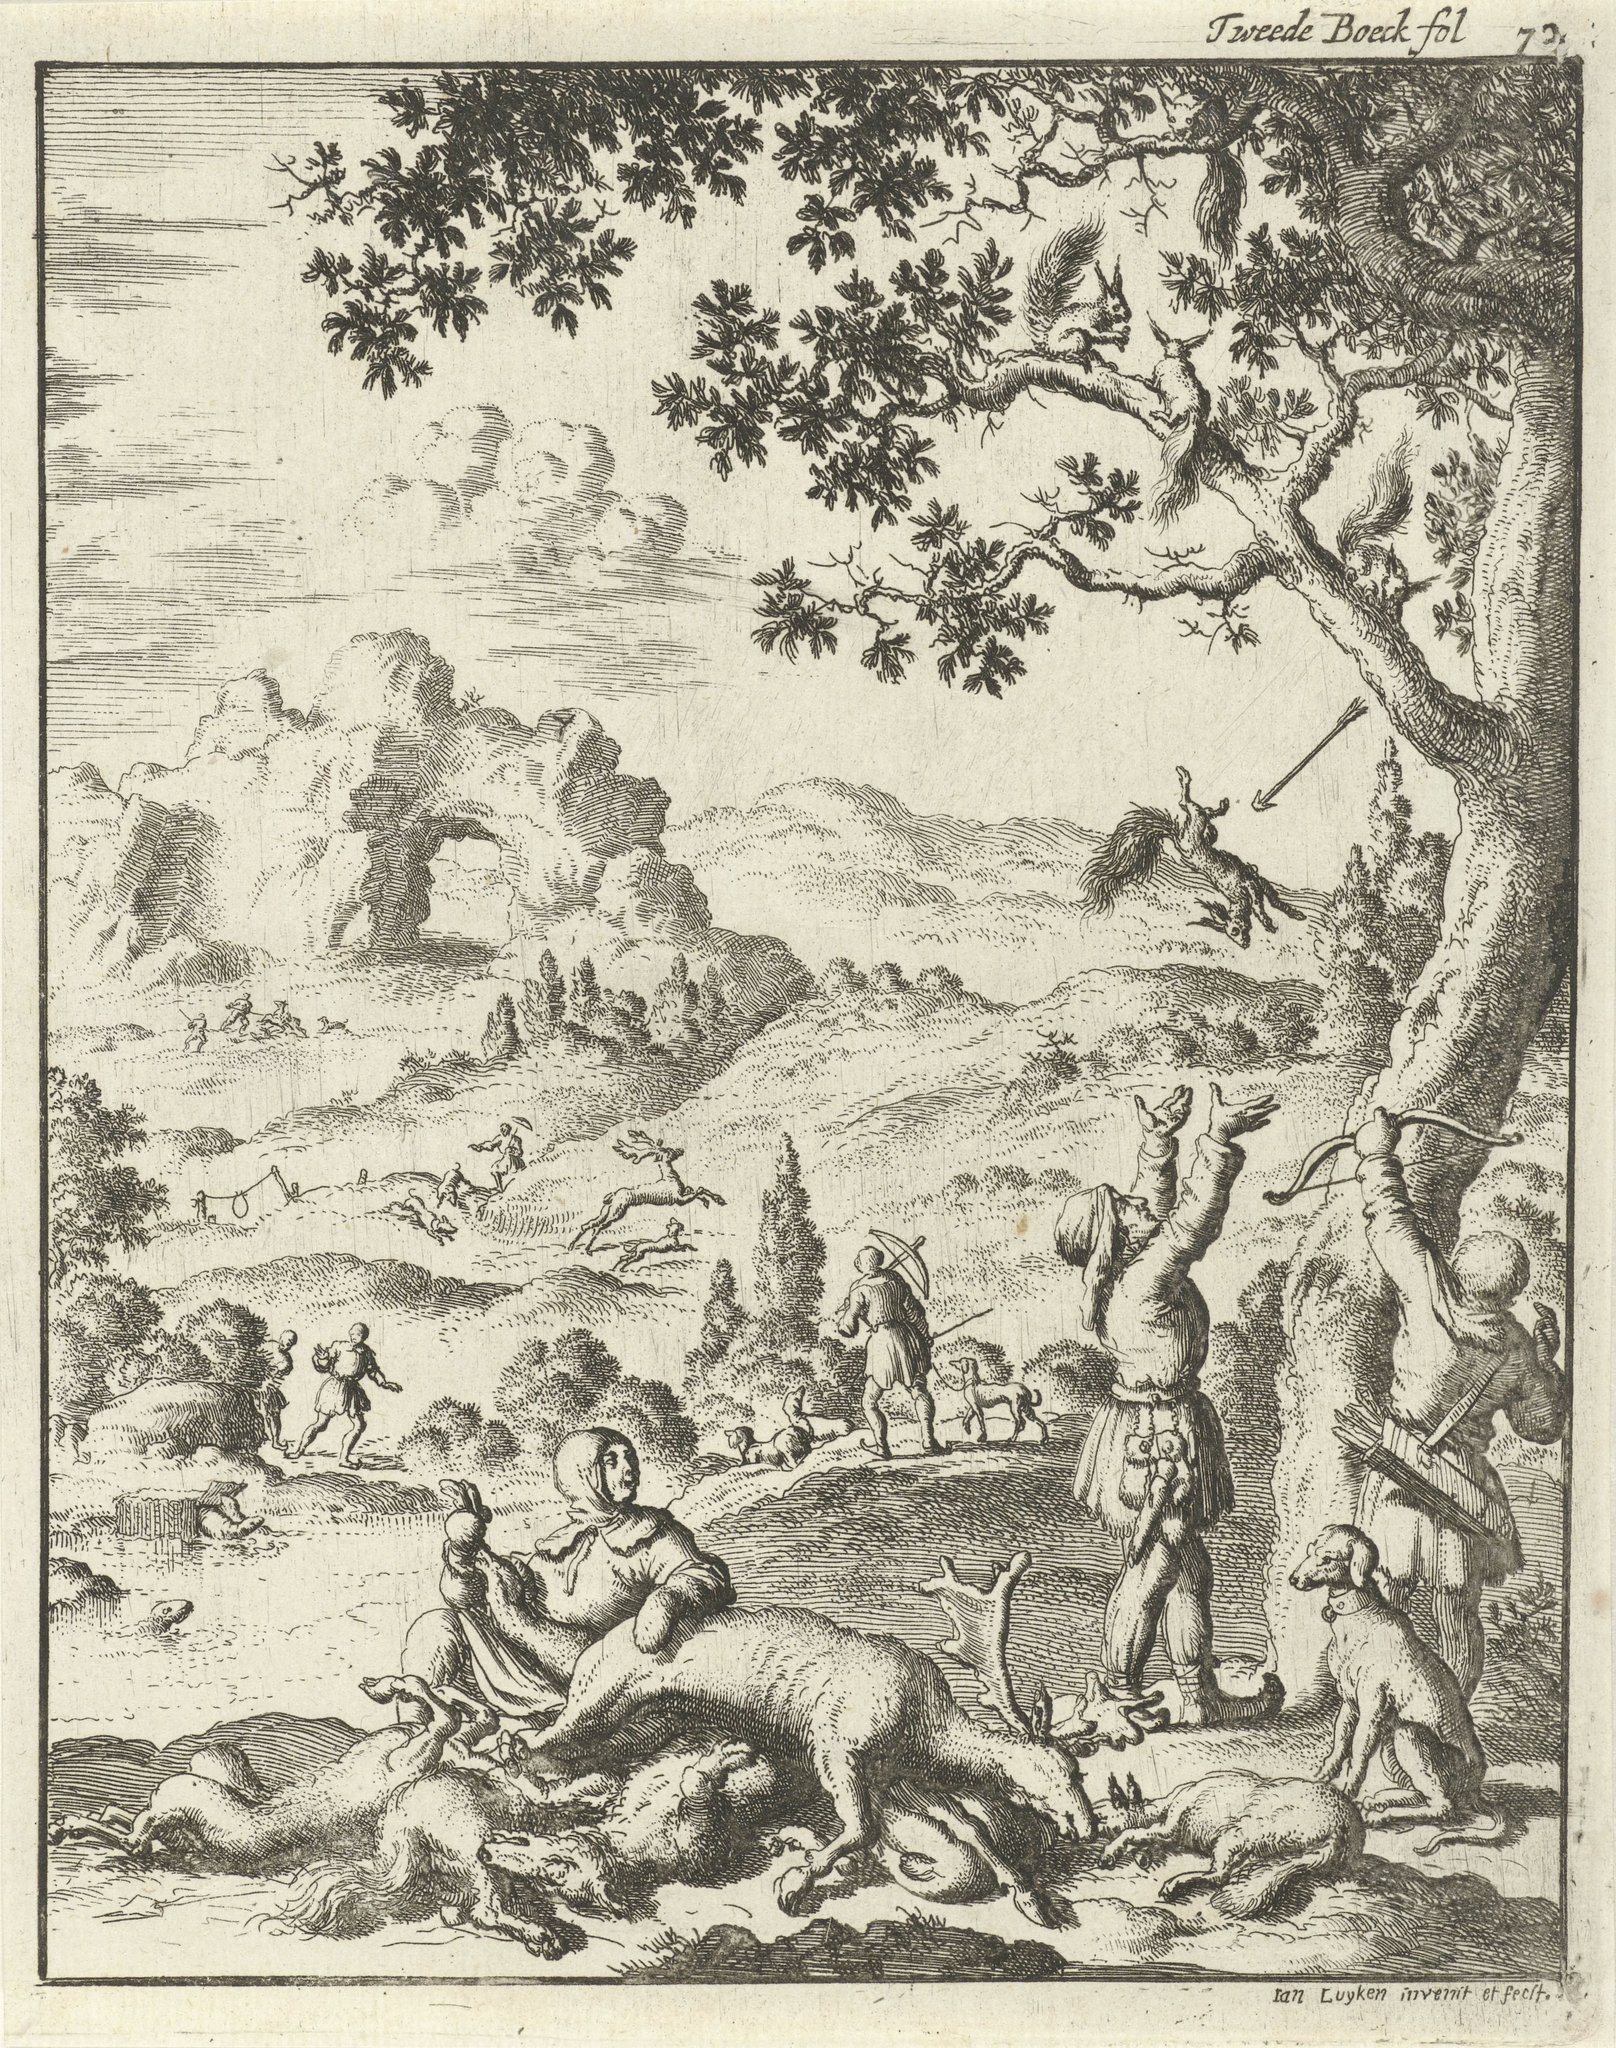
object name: print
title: Laplanders op jacht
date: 1682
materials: paper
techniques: etching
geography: amsterdam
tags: europeans: sami, hunting, chase, sápmi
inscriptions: collector's mark: Lugt 2228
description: Illustratie opgenomen in: Scheffer, Johannes. Waarachtige en aen-merkens-waardige historie van Lapland. Amsterdam: Jan Claesz ten Hoorn, 1682.